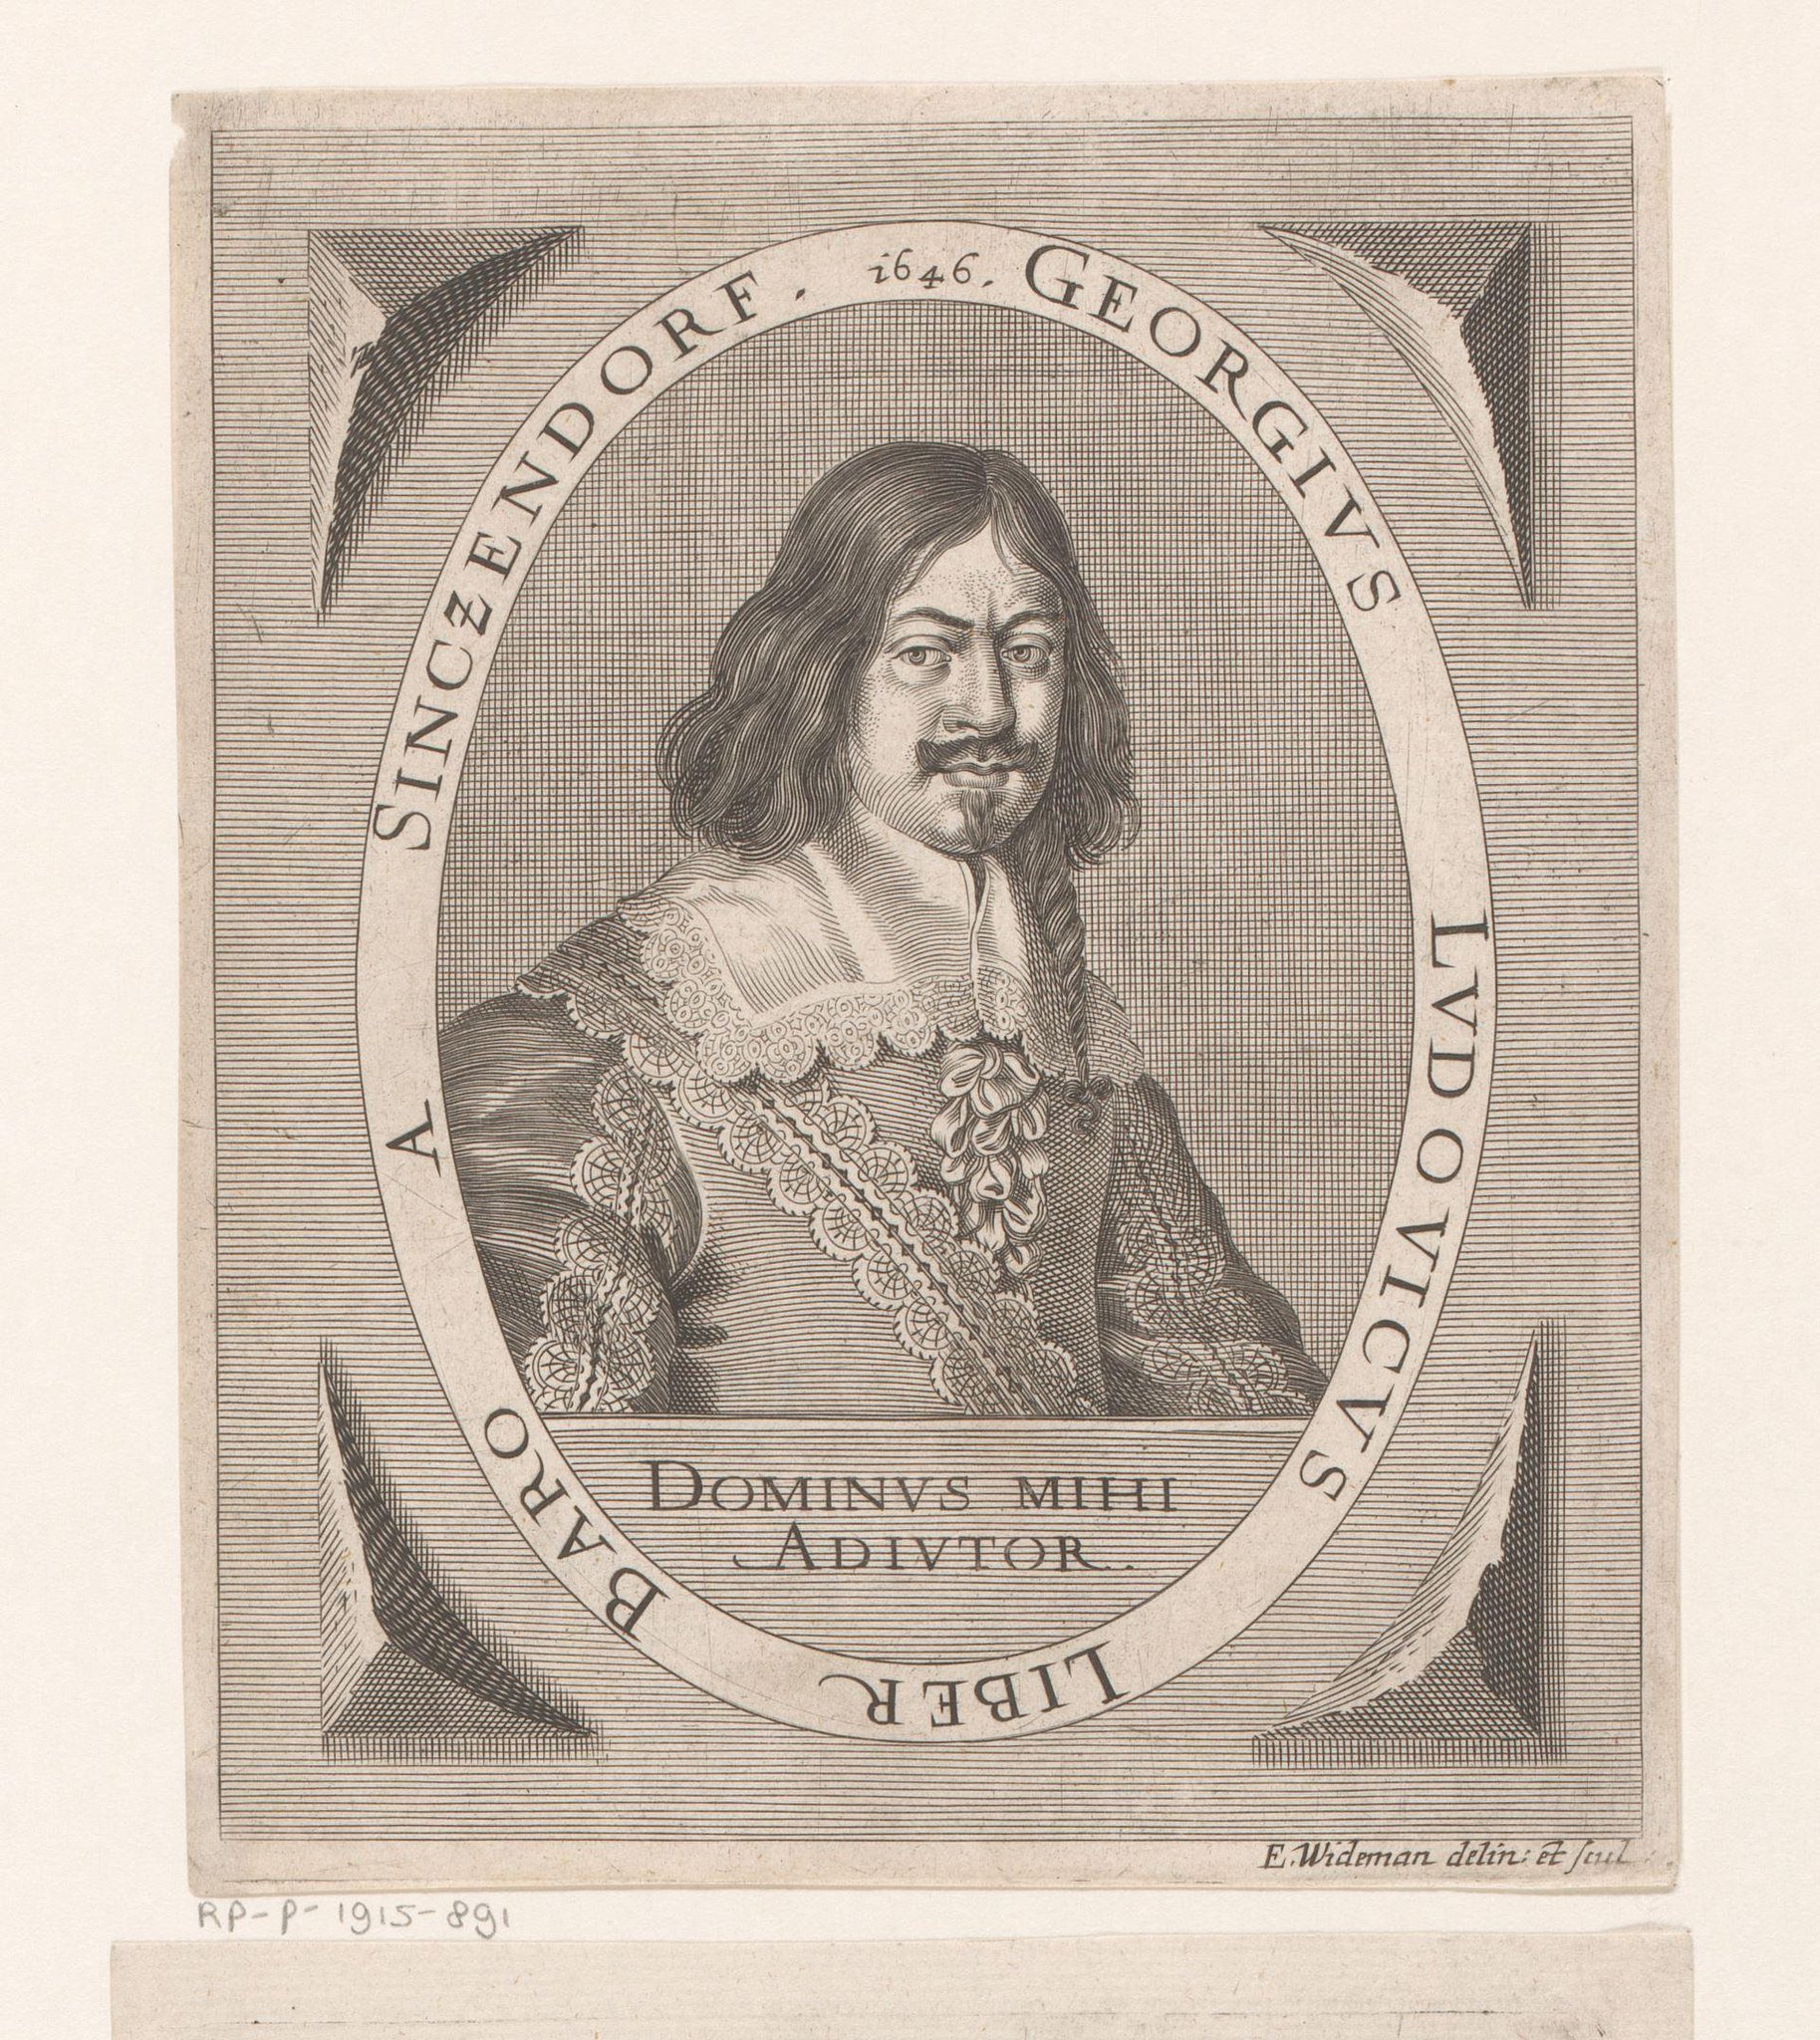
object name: print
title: Portret van Georg Ludwig graaf van Sinzendorf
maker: elias widemann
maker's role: print maker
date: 1646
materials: paper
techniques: engraving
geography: vienna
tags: vienna, historical persons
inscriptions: collector's mark: Lugt 2228